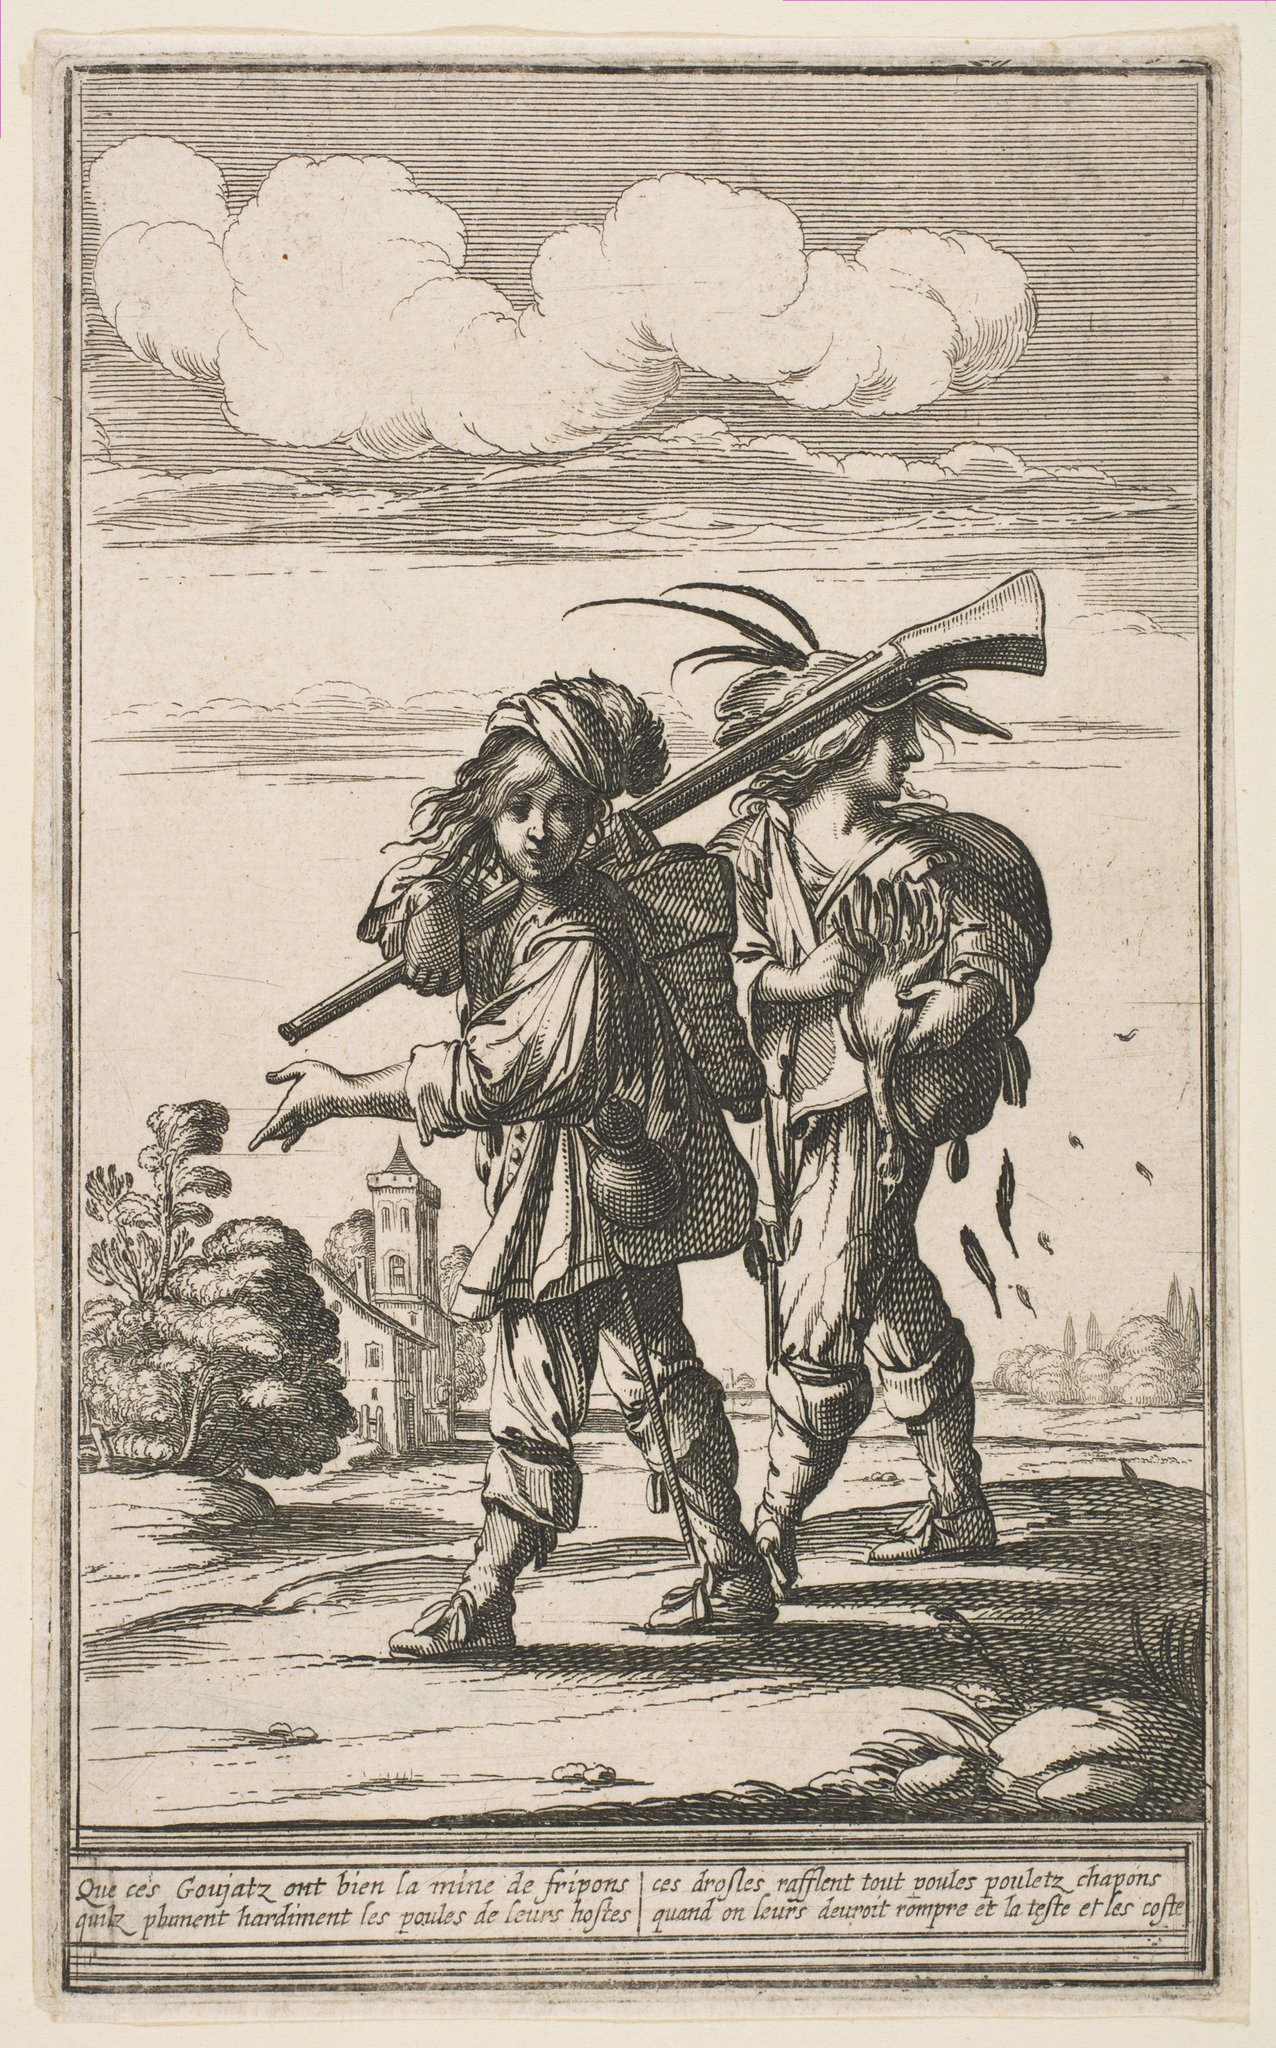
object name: print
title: Two Marauders, from "The French Guards" (Les Gardes Françaises)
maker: abraham bosse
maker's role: artist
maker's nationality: french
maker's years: 1602-1676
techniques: etching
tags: firearms,women